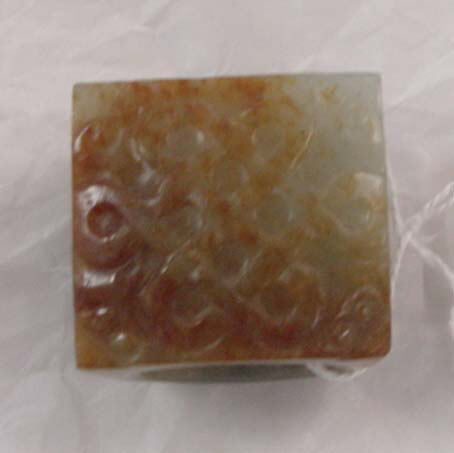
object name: ring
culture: chinese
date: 1801-1900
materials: jade